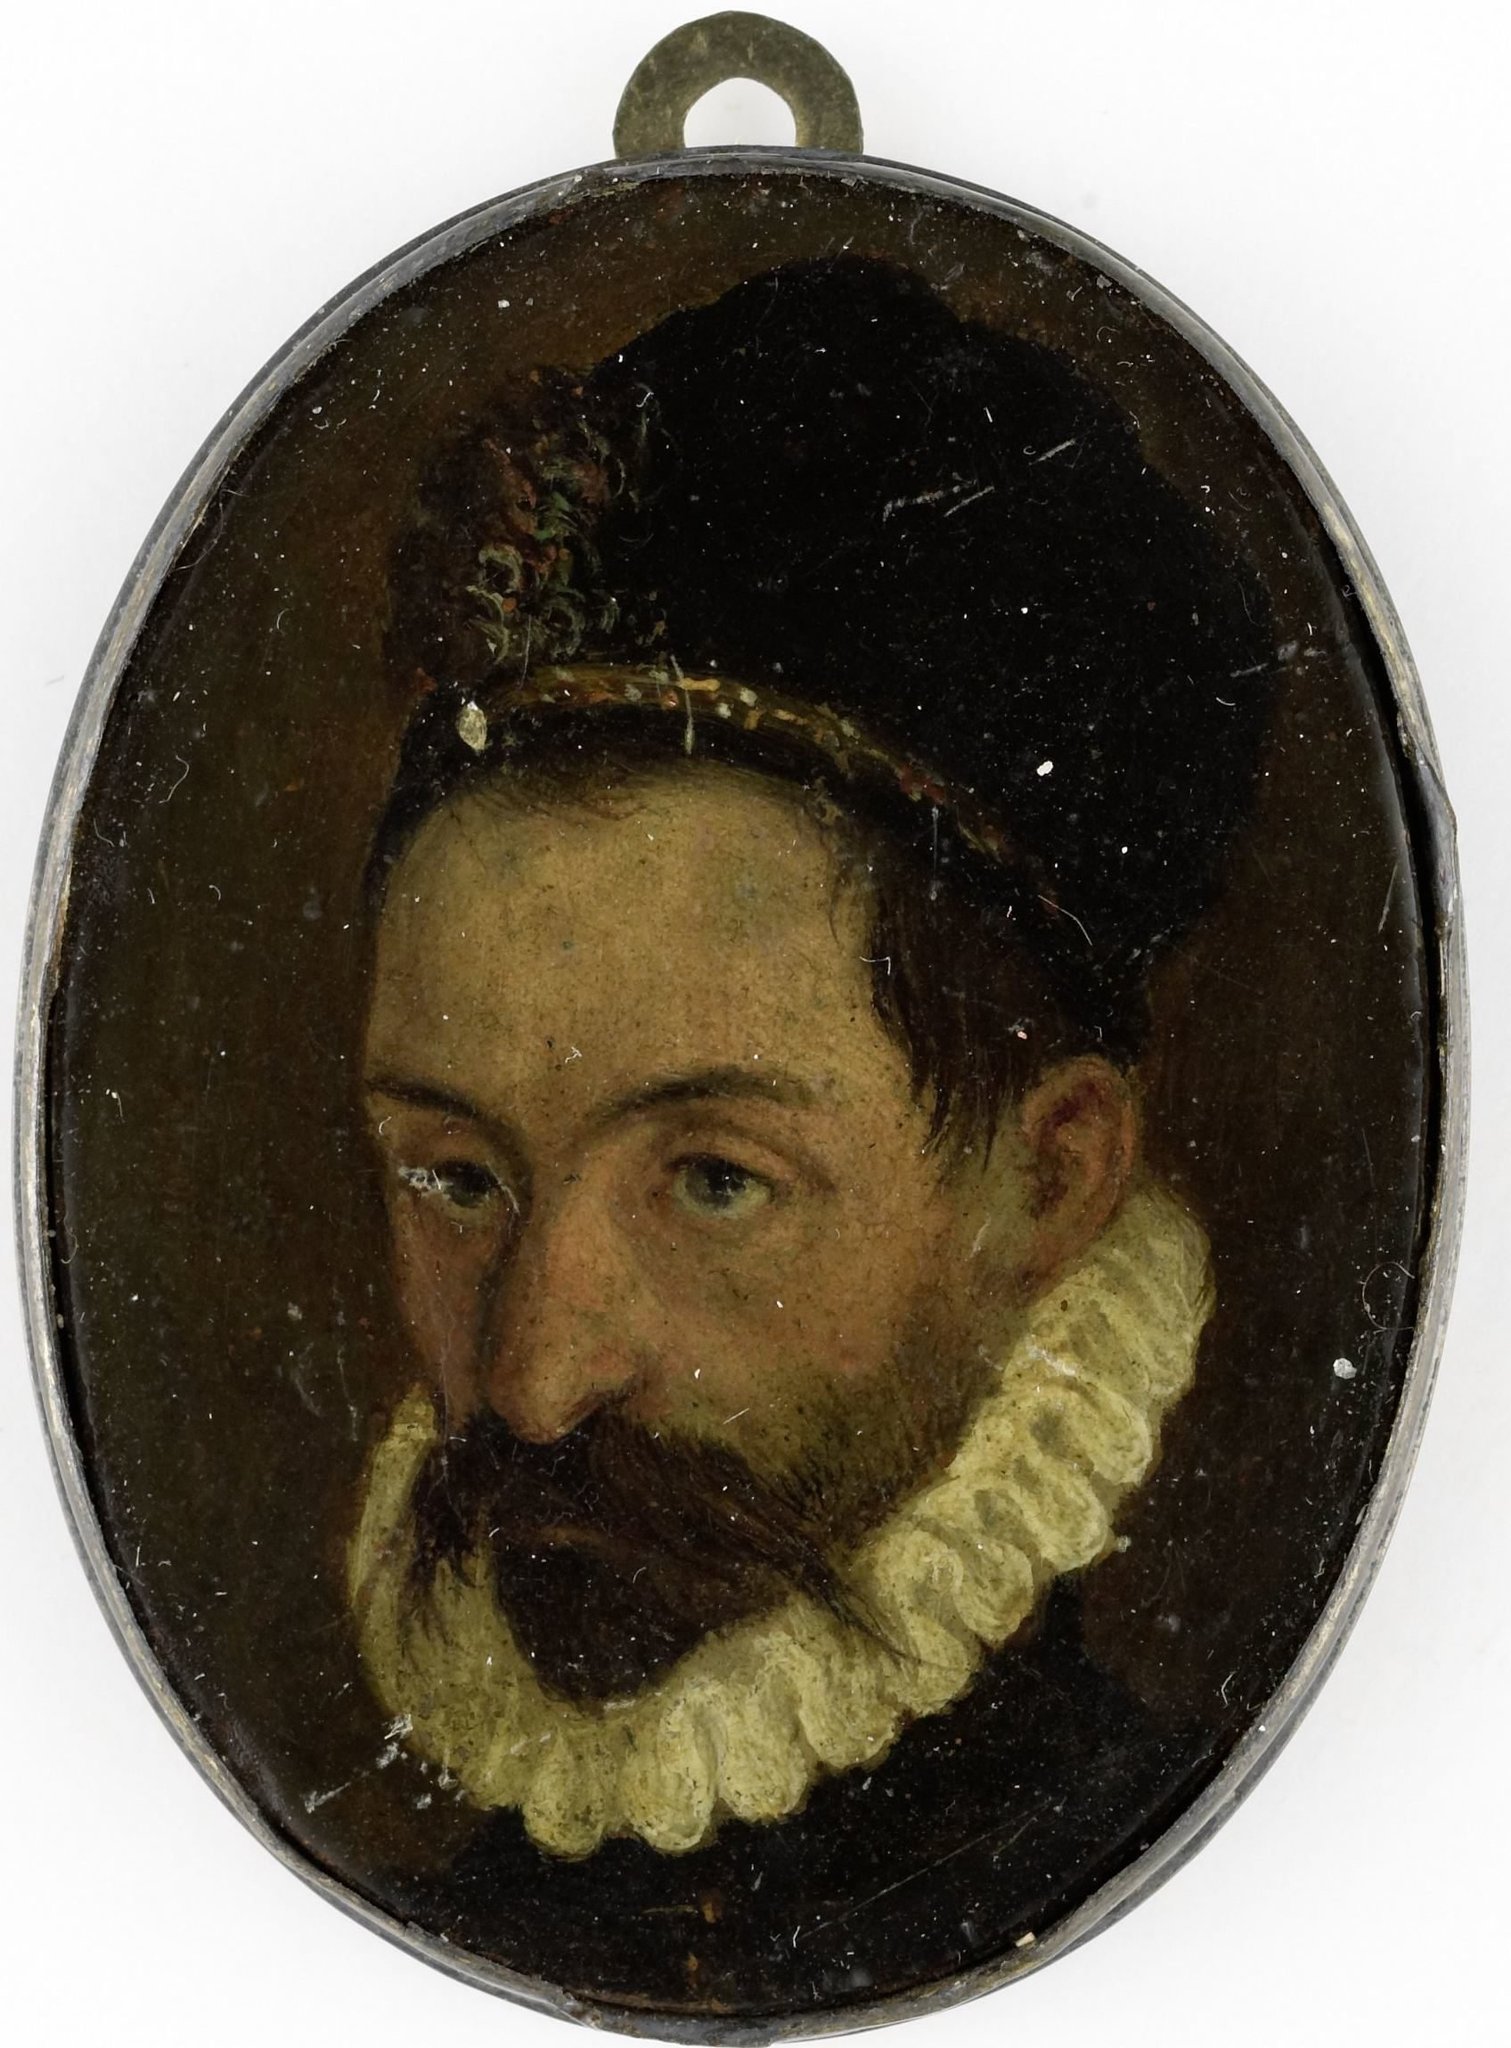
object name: painting, miniature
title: Portret van een man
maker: Anonymous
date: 1575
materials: copper, oil, silver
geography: low countries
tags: historical persons not known by name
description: Portret van een man. Buste naar links, met een hoge muts. Onderdeel van de collectie portretminiaturen.